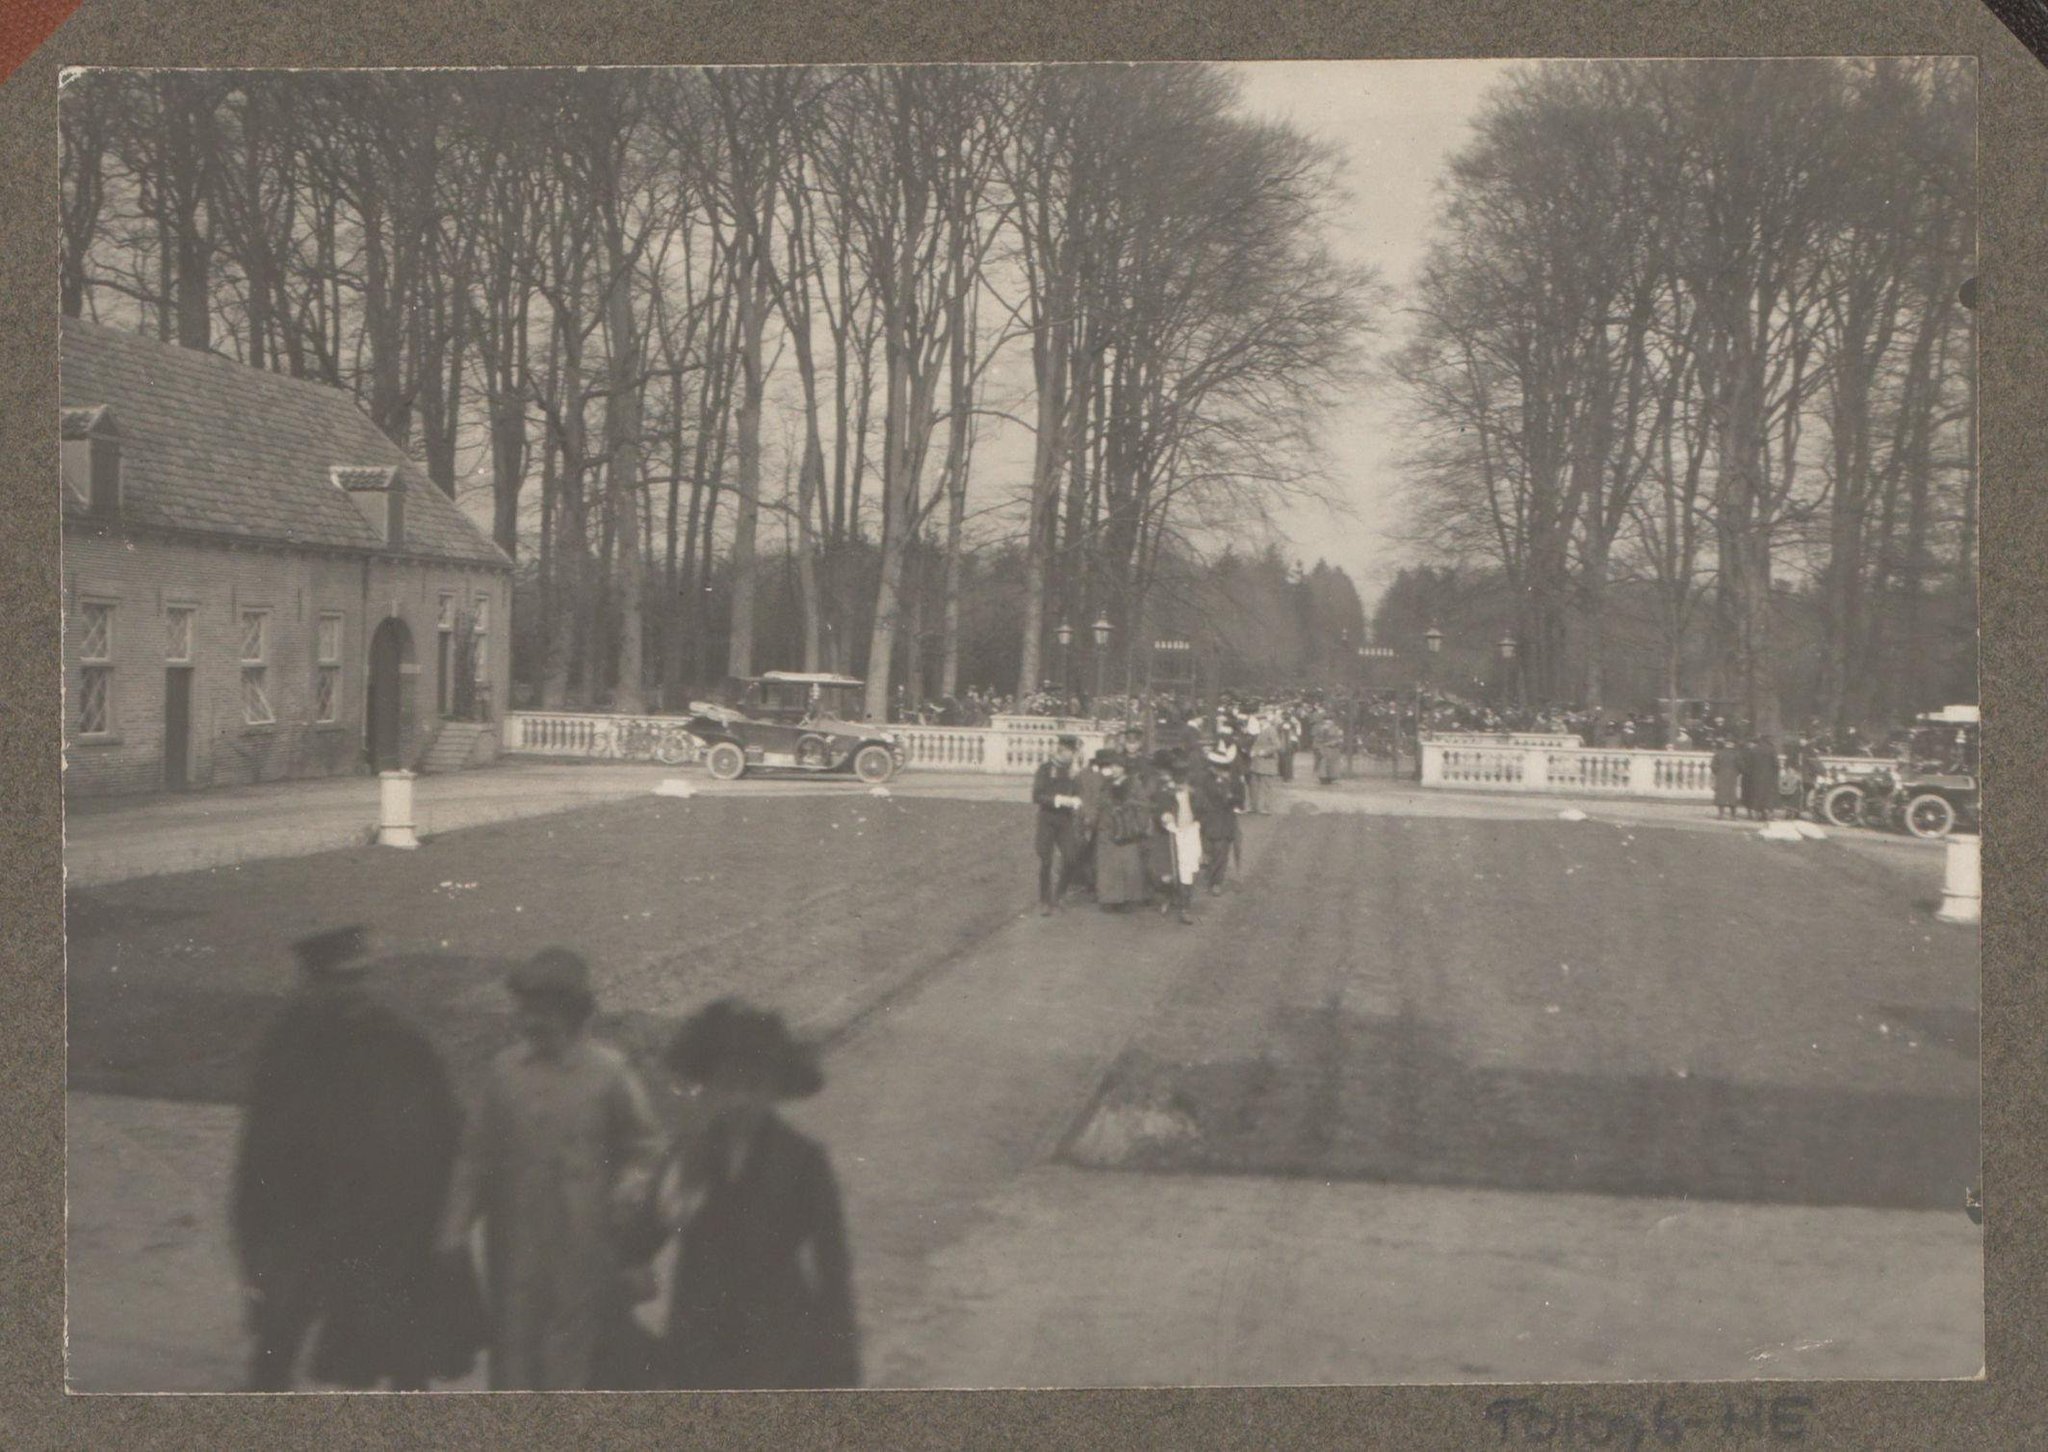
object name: photograph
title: Ruitertafereel op Koninklijke Houtvesterij Het Loo: gezelschap loopt door hek en tuin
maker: Anonymous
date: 1900-1925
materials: photographic support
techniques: gelatin silver print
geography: het loo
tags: riding a horse, ass, or mule; rider, horseman, hunting, chase, hunting-ground, garden, gate, entrance, automobile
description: Onderdeel van Fotoalbum van de heer Brams, opperhoutvester van koningin Wilhelmina op Koninklijke Houtvesterij Het Loo.